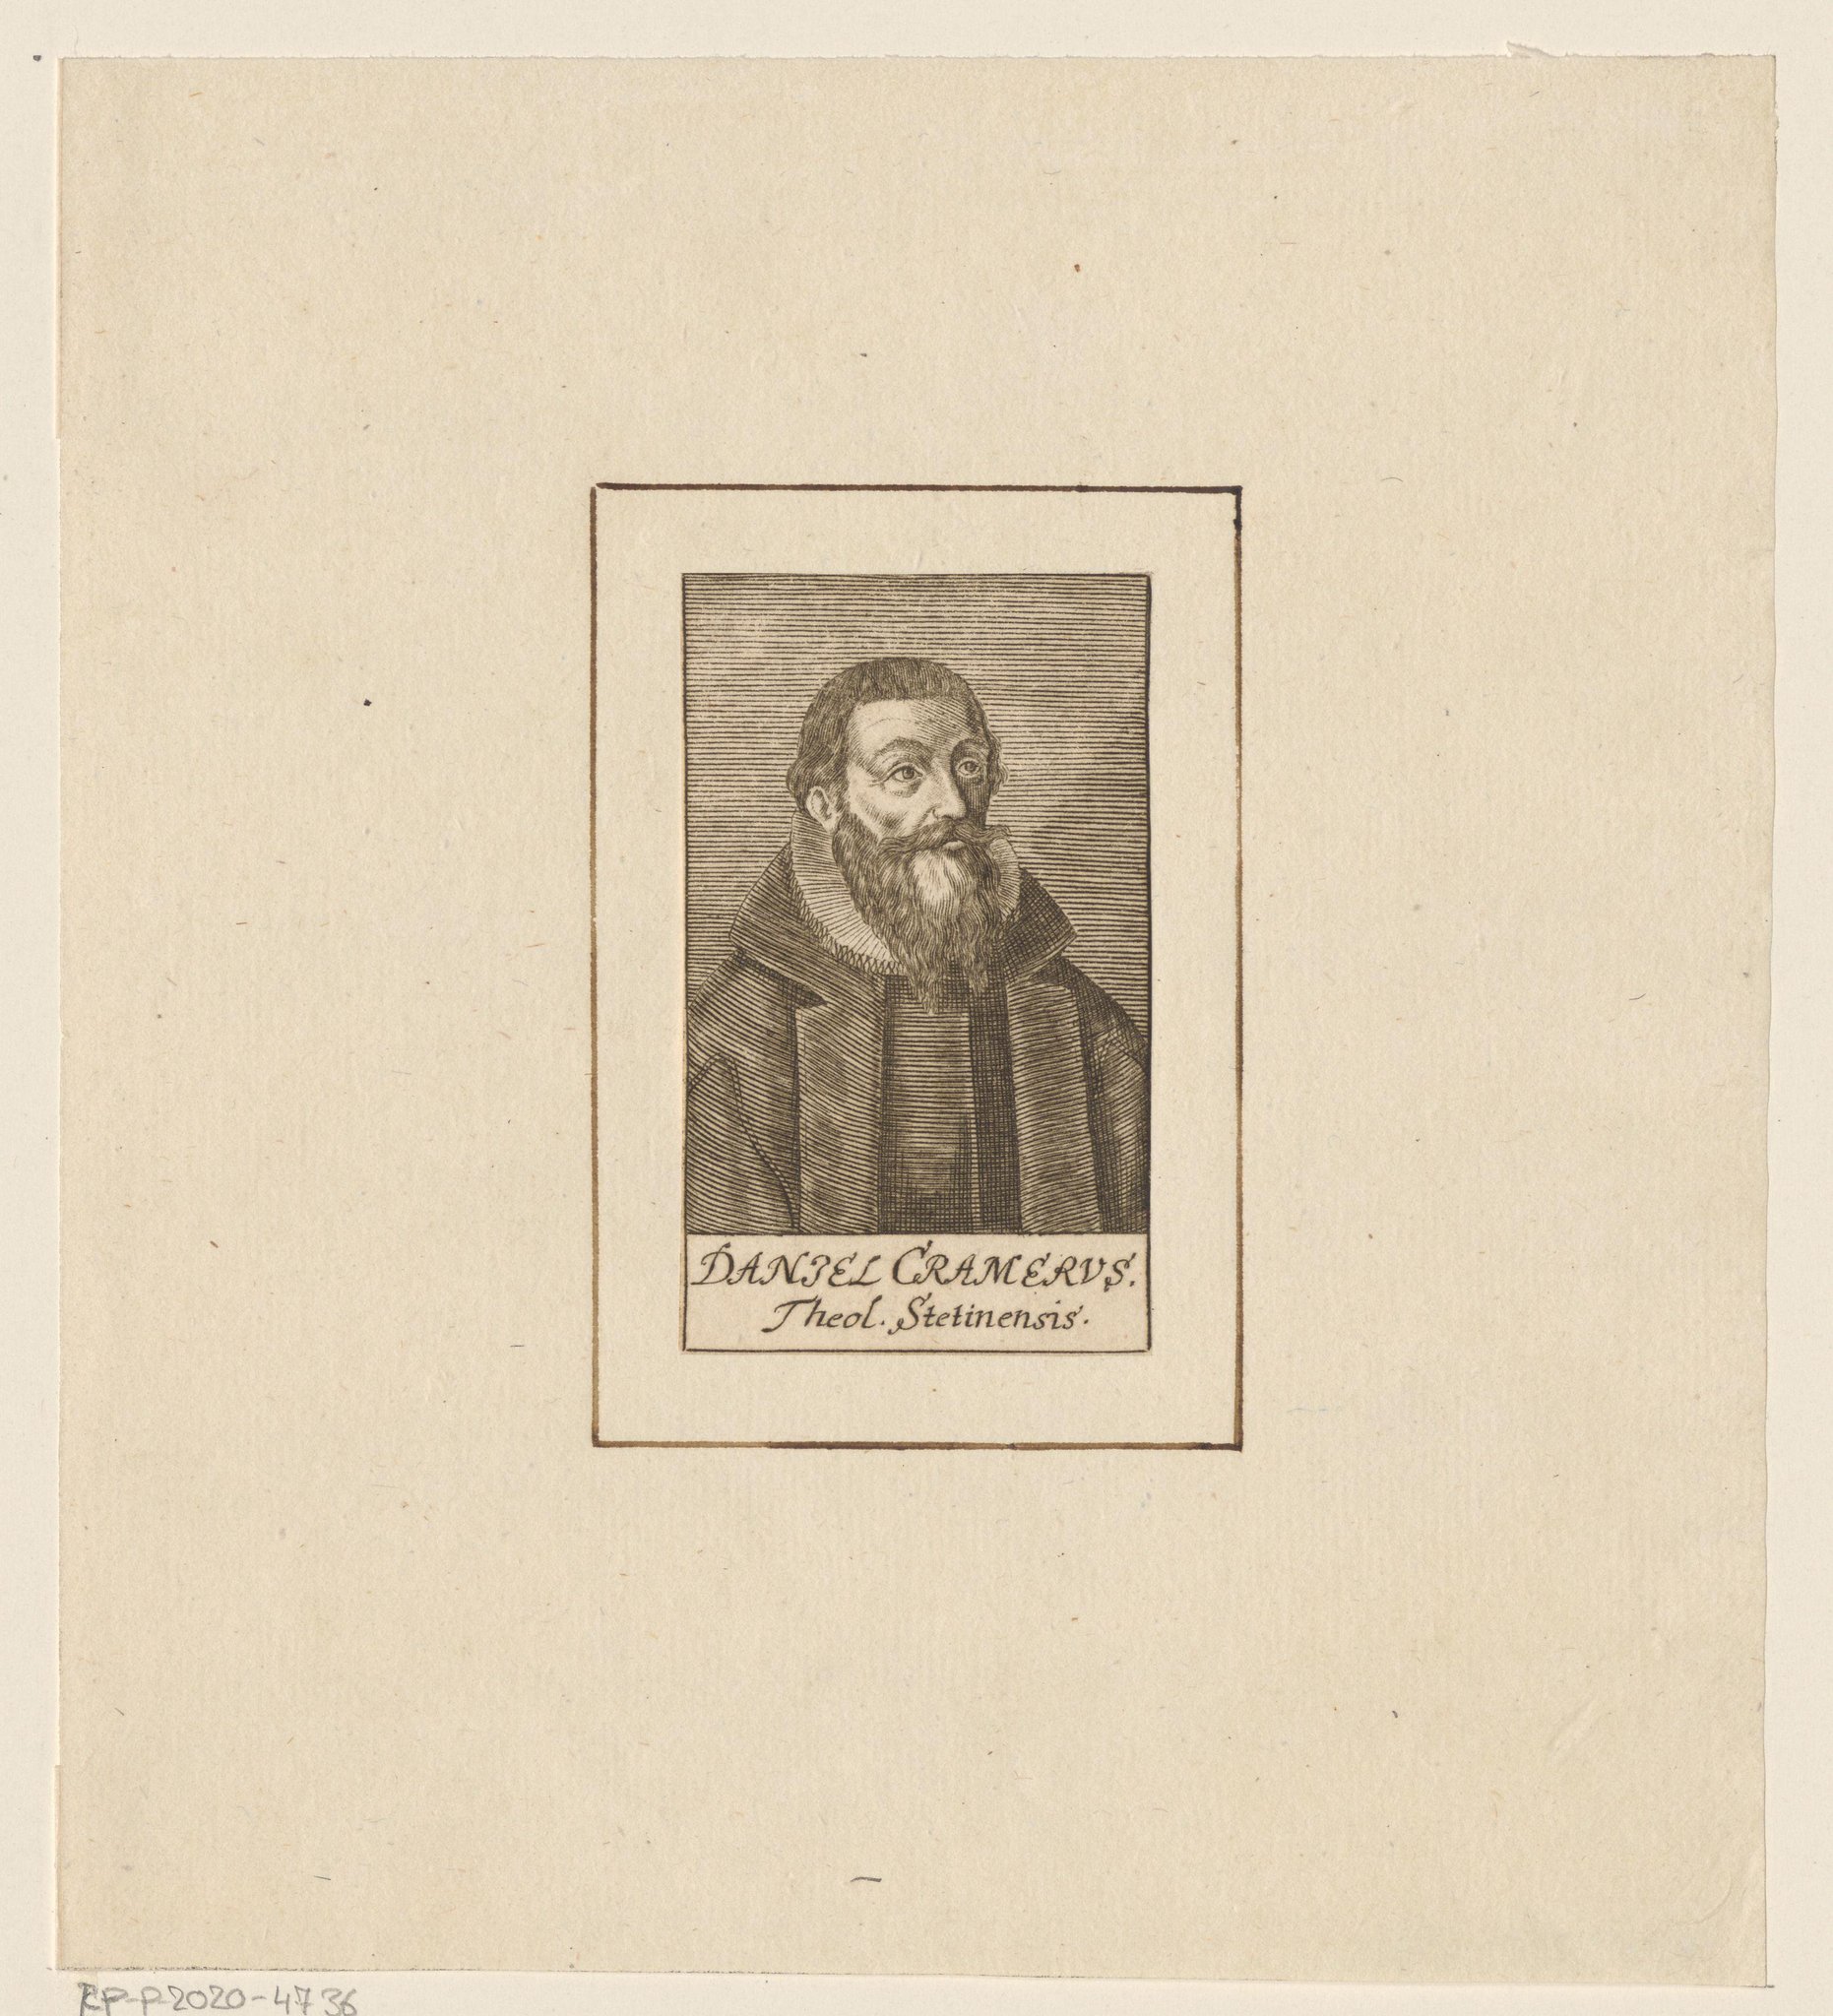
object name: print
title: Portret van Daniel Cramer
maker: Anonymous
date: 1688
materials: paper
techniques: engraving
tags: theologian, historical persons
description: Prent maakt deel uit van een grotere prent die later is verknipt. Prent waarschijnlijk uit: Freher, Paul. Theatrum virorum eruditione clarorum. Neurenberg: Johann Hoffmann, 1688.